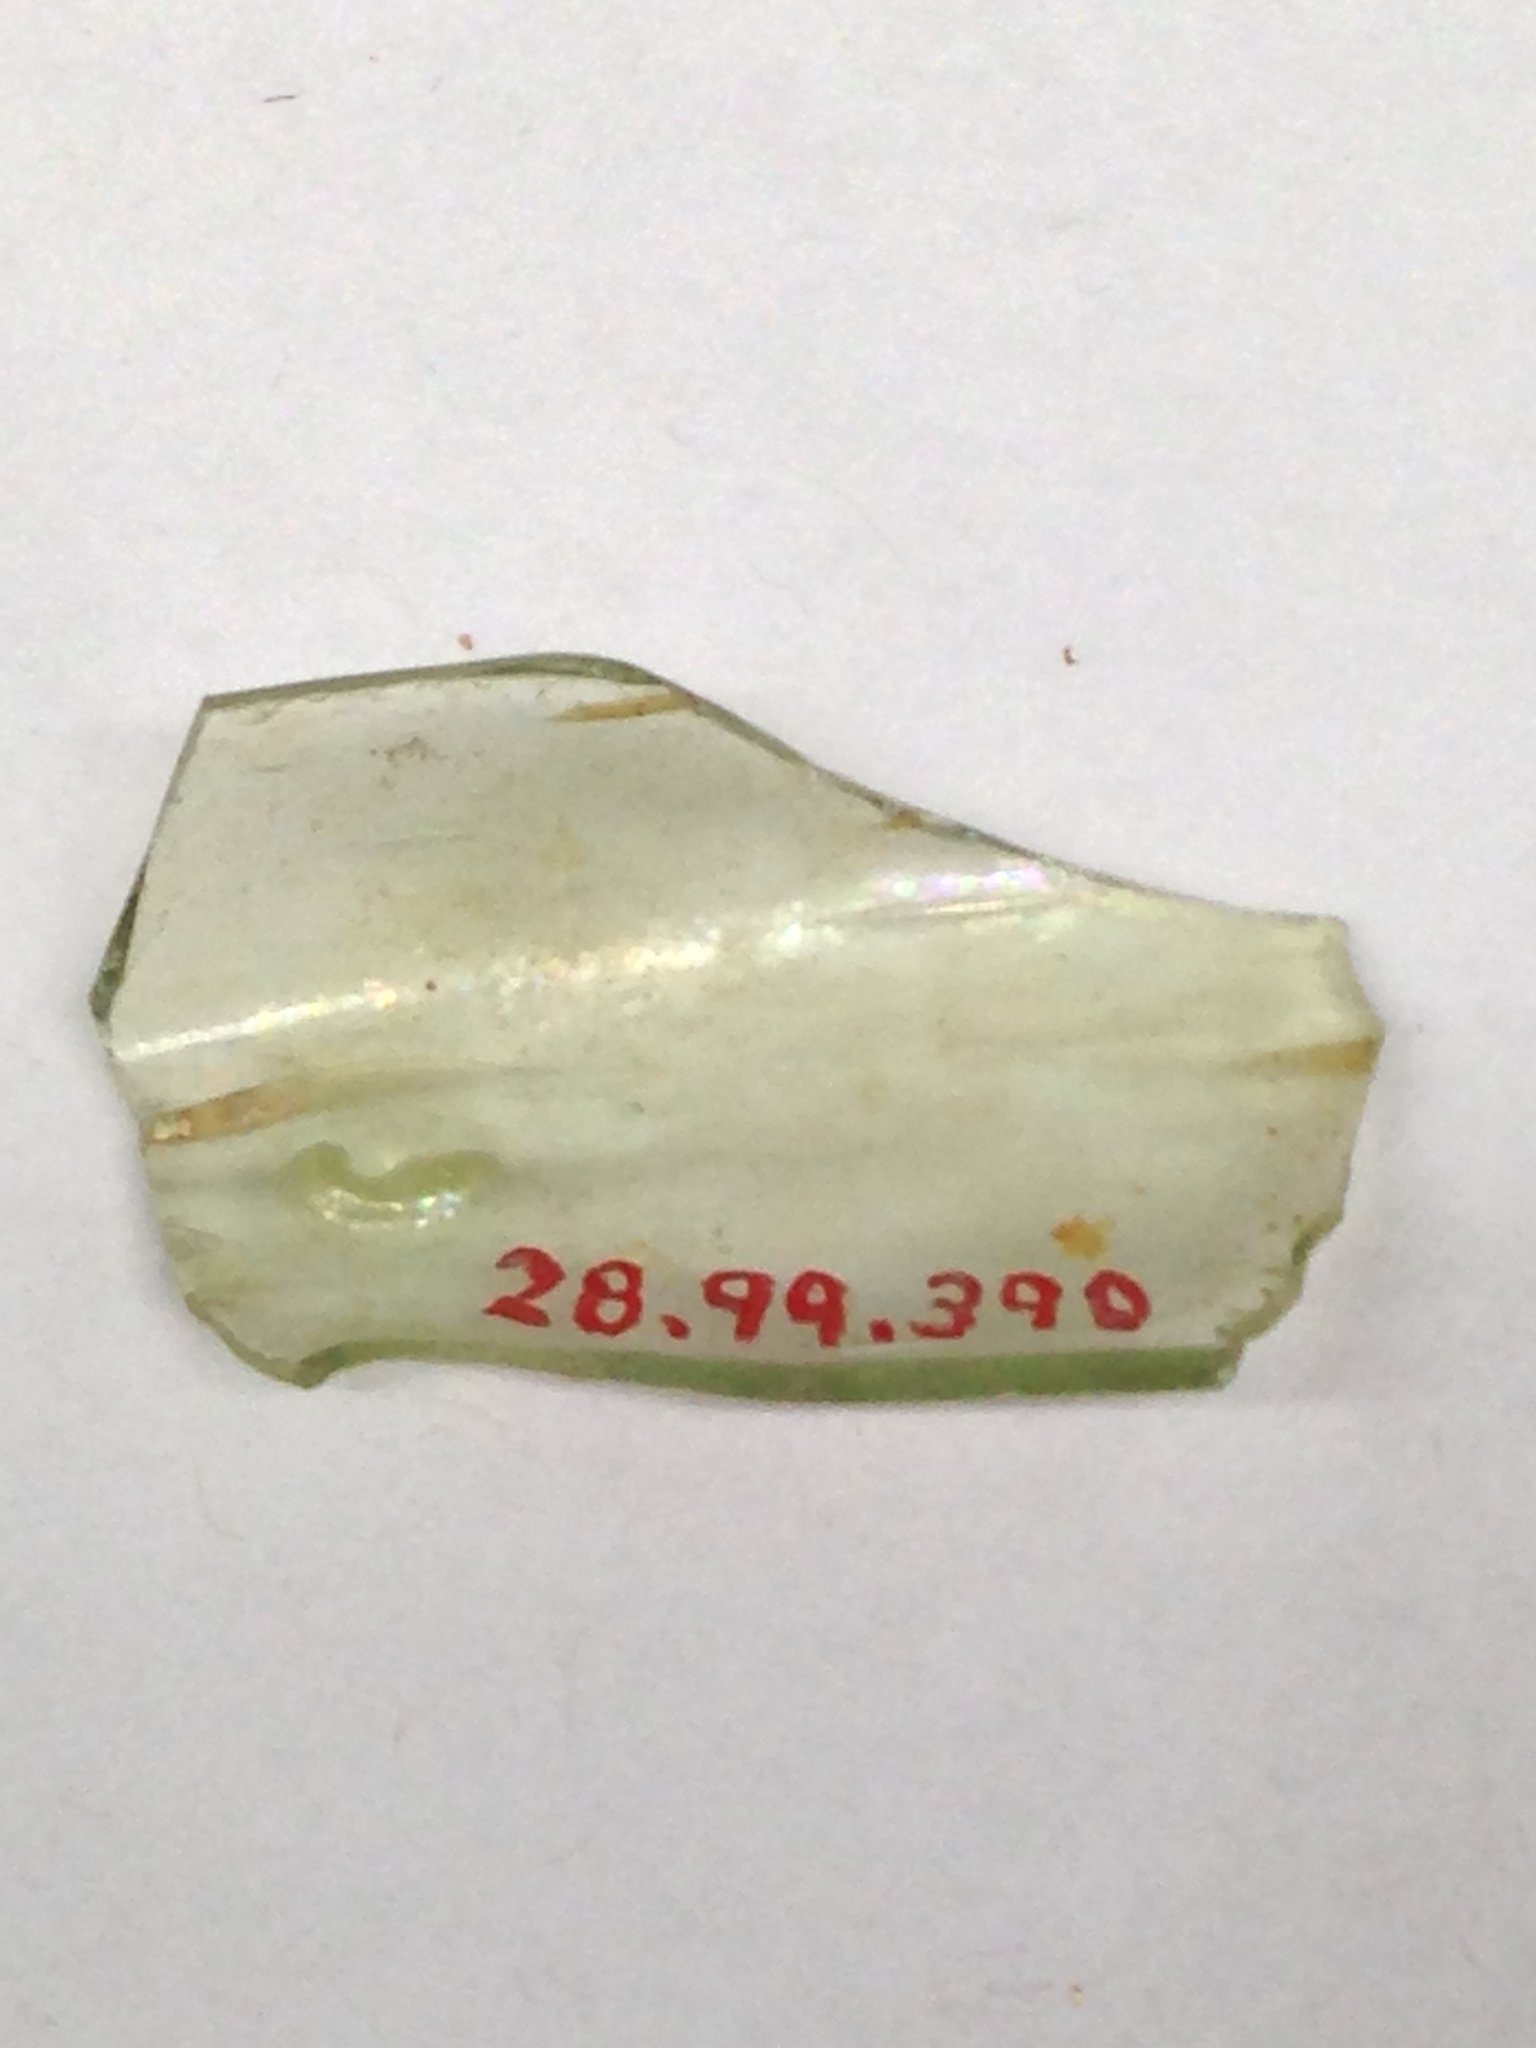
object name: fragment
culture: european or middle eastern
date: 1150-1250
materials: ceramic, glass